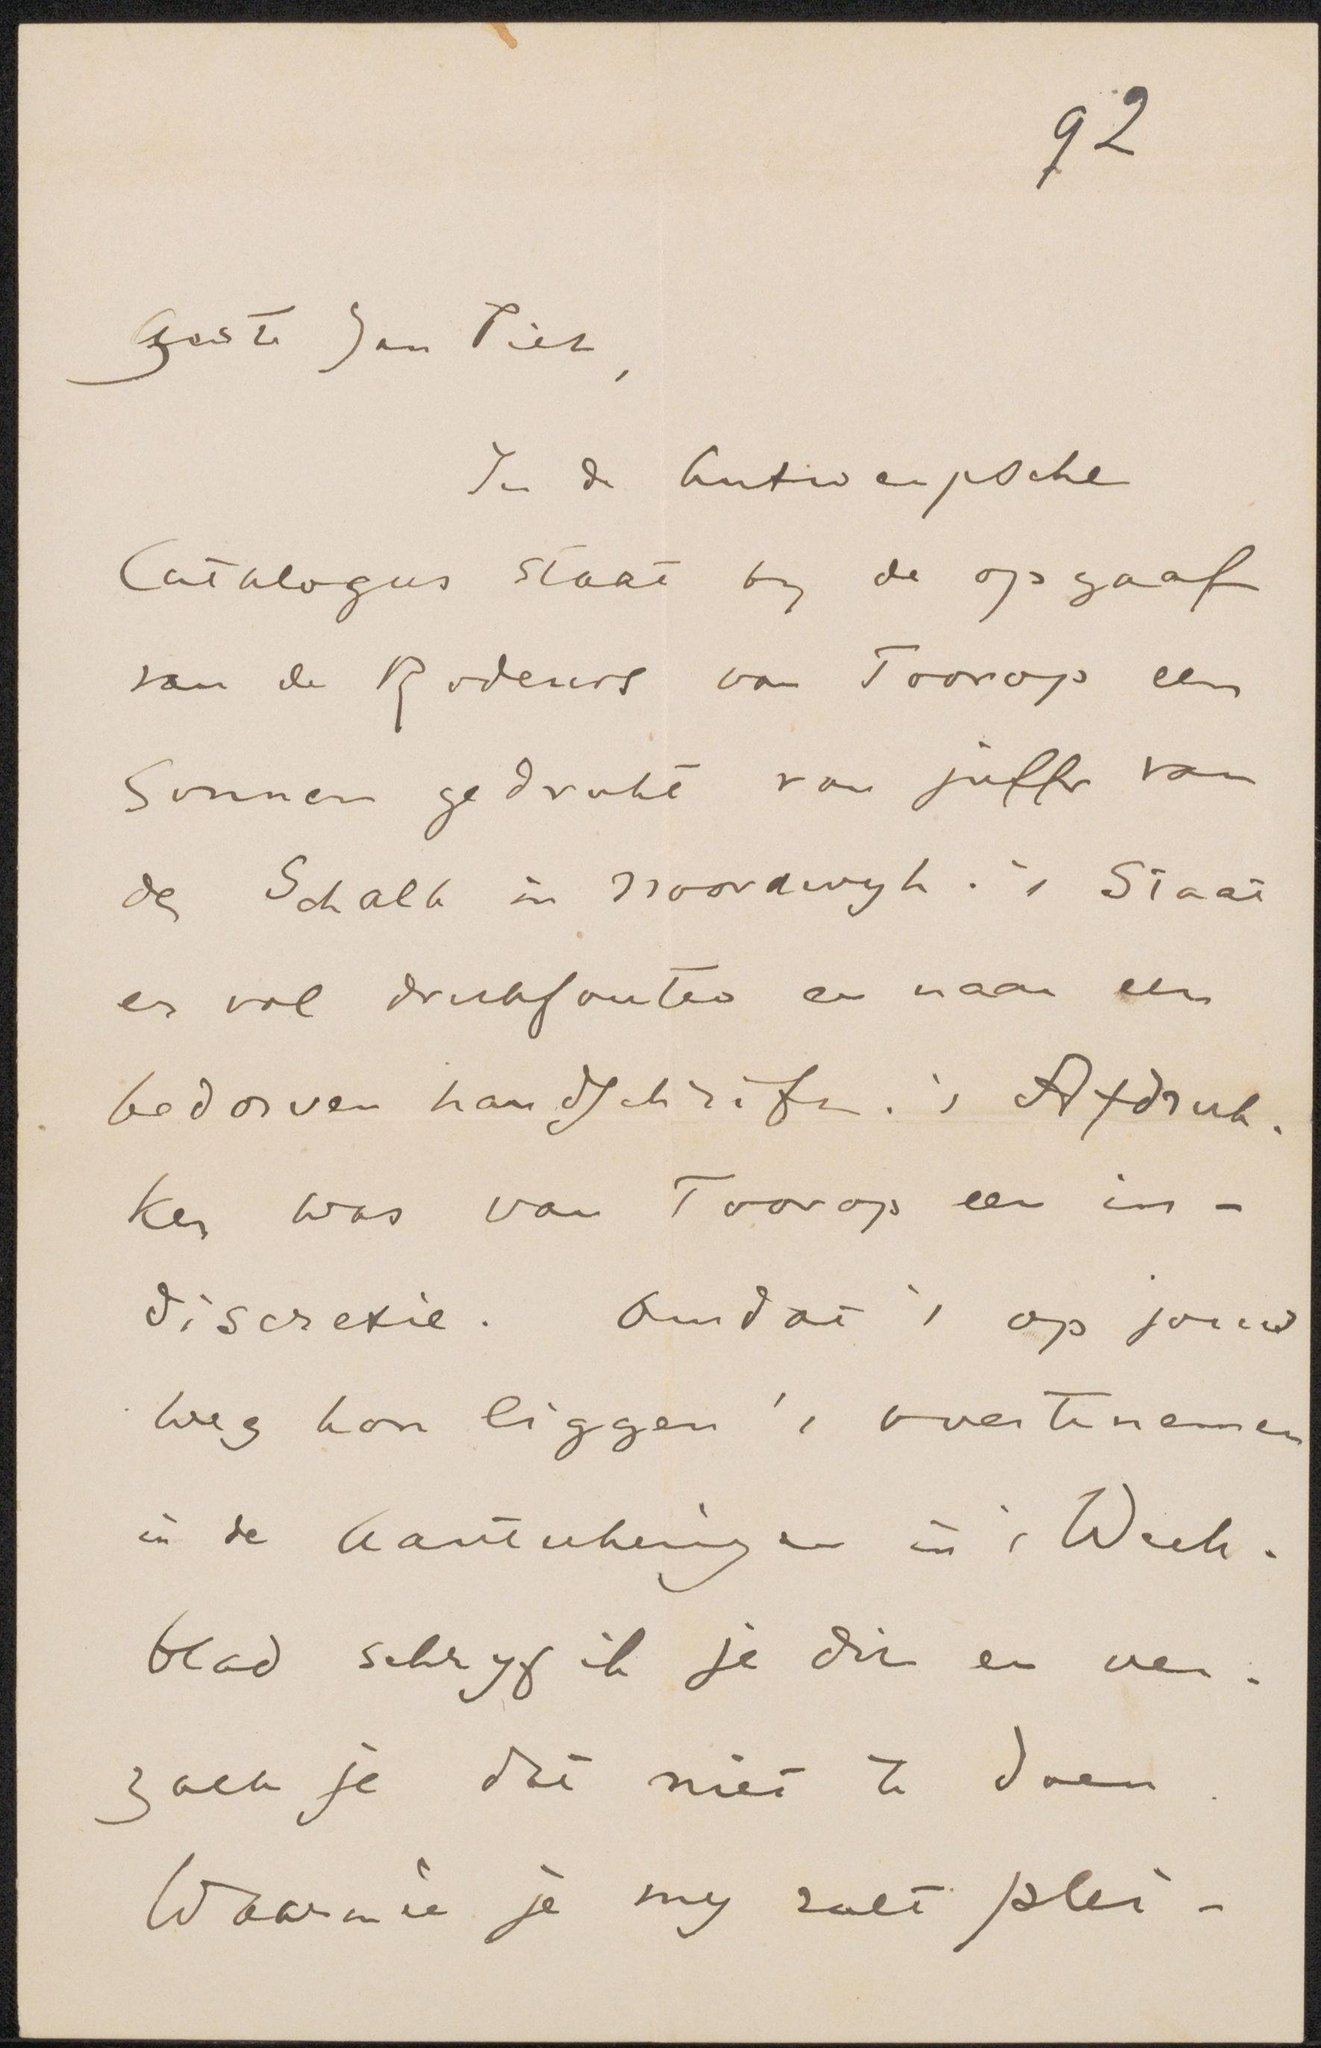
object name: letter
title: Brief aan Jan Veth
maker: albert verwey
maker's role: criticus, dichter, essayist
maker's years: 1865-1937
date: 1875-1925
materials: ink, paper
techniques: pen, writing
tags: dordrecht, painter, print maker, draughtsman, designer, jan veth, the hague, jan toorop, henriëtte roland holst-van der schalk, drawing, printed matter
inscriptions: collector's mark: ‘RPK’